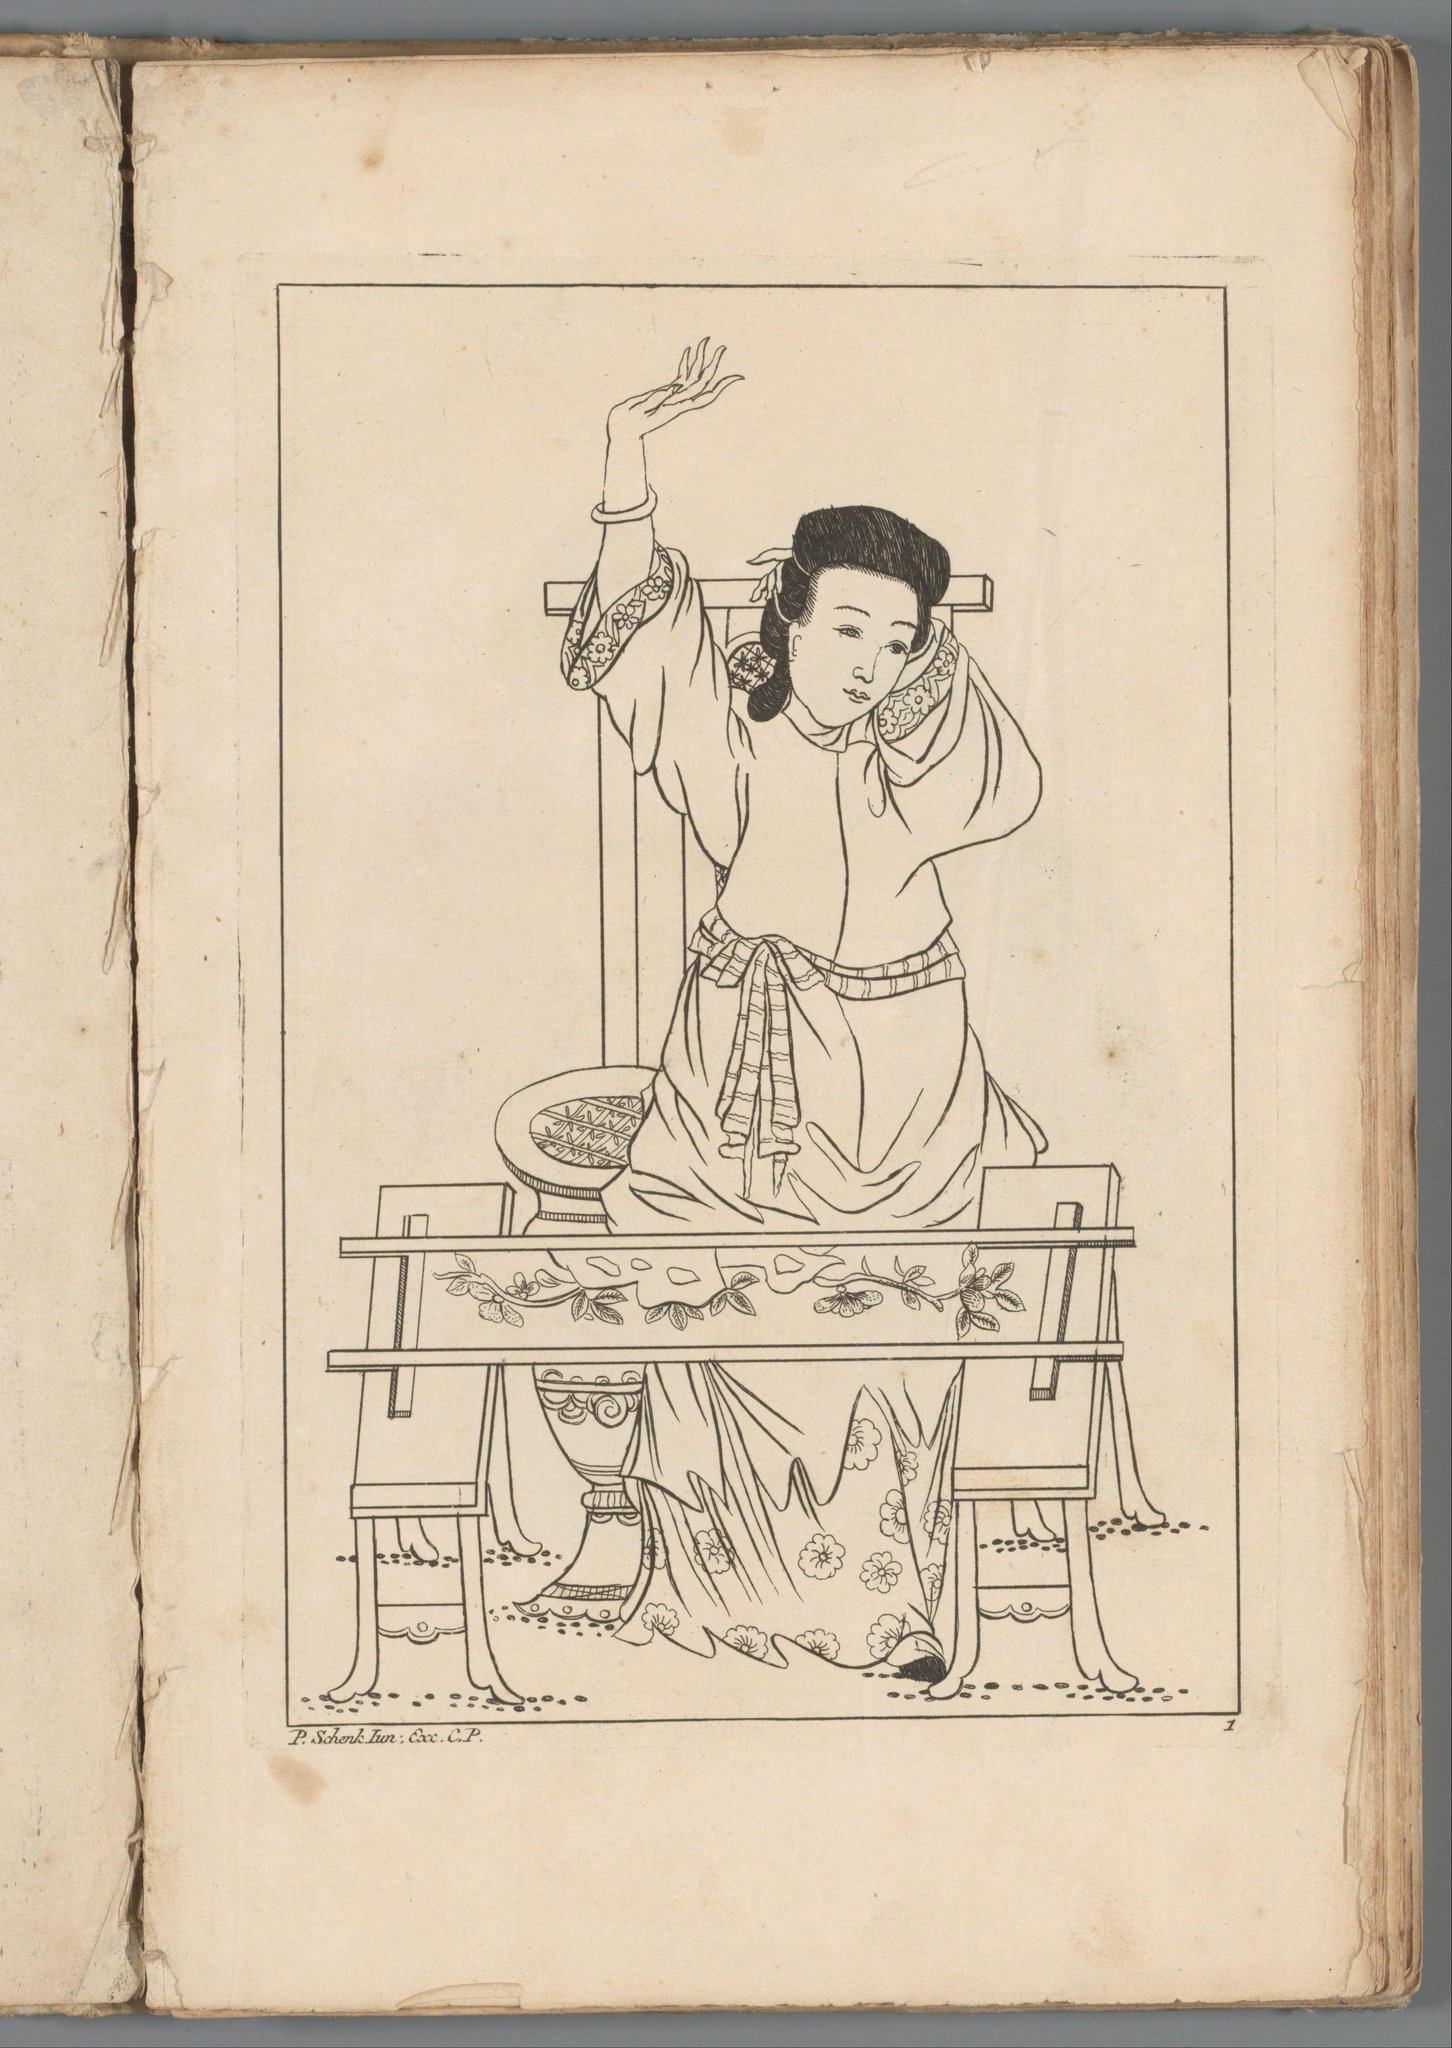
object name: print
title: Chinese vrouwen, bloemen en vogels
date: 1727-1775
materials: paper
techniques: etching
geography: amsterdam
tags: embroidering ~ textile industry, chinese (+ costume)